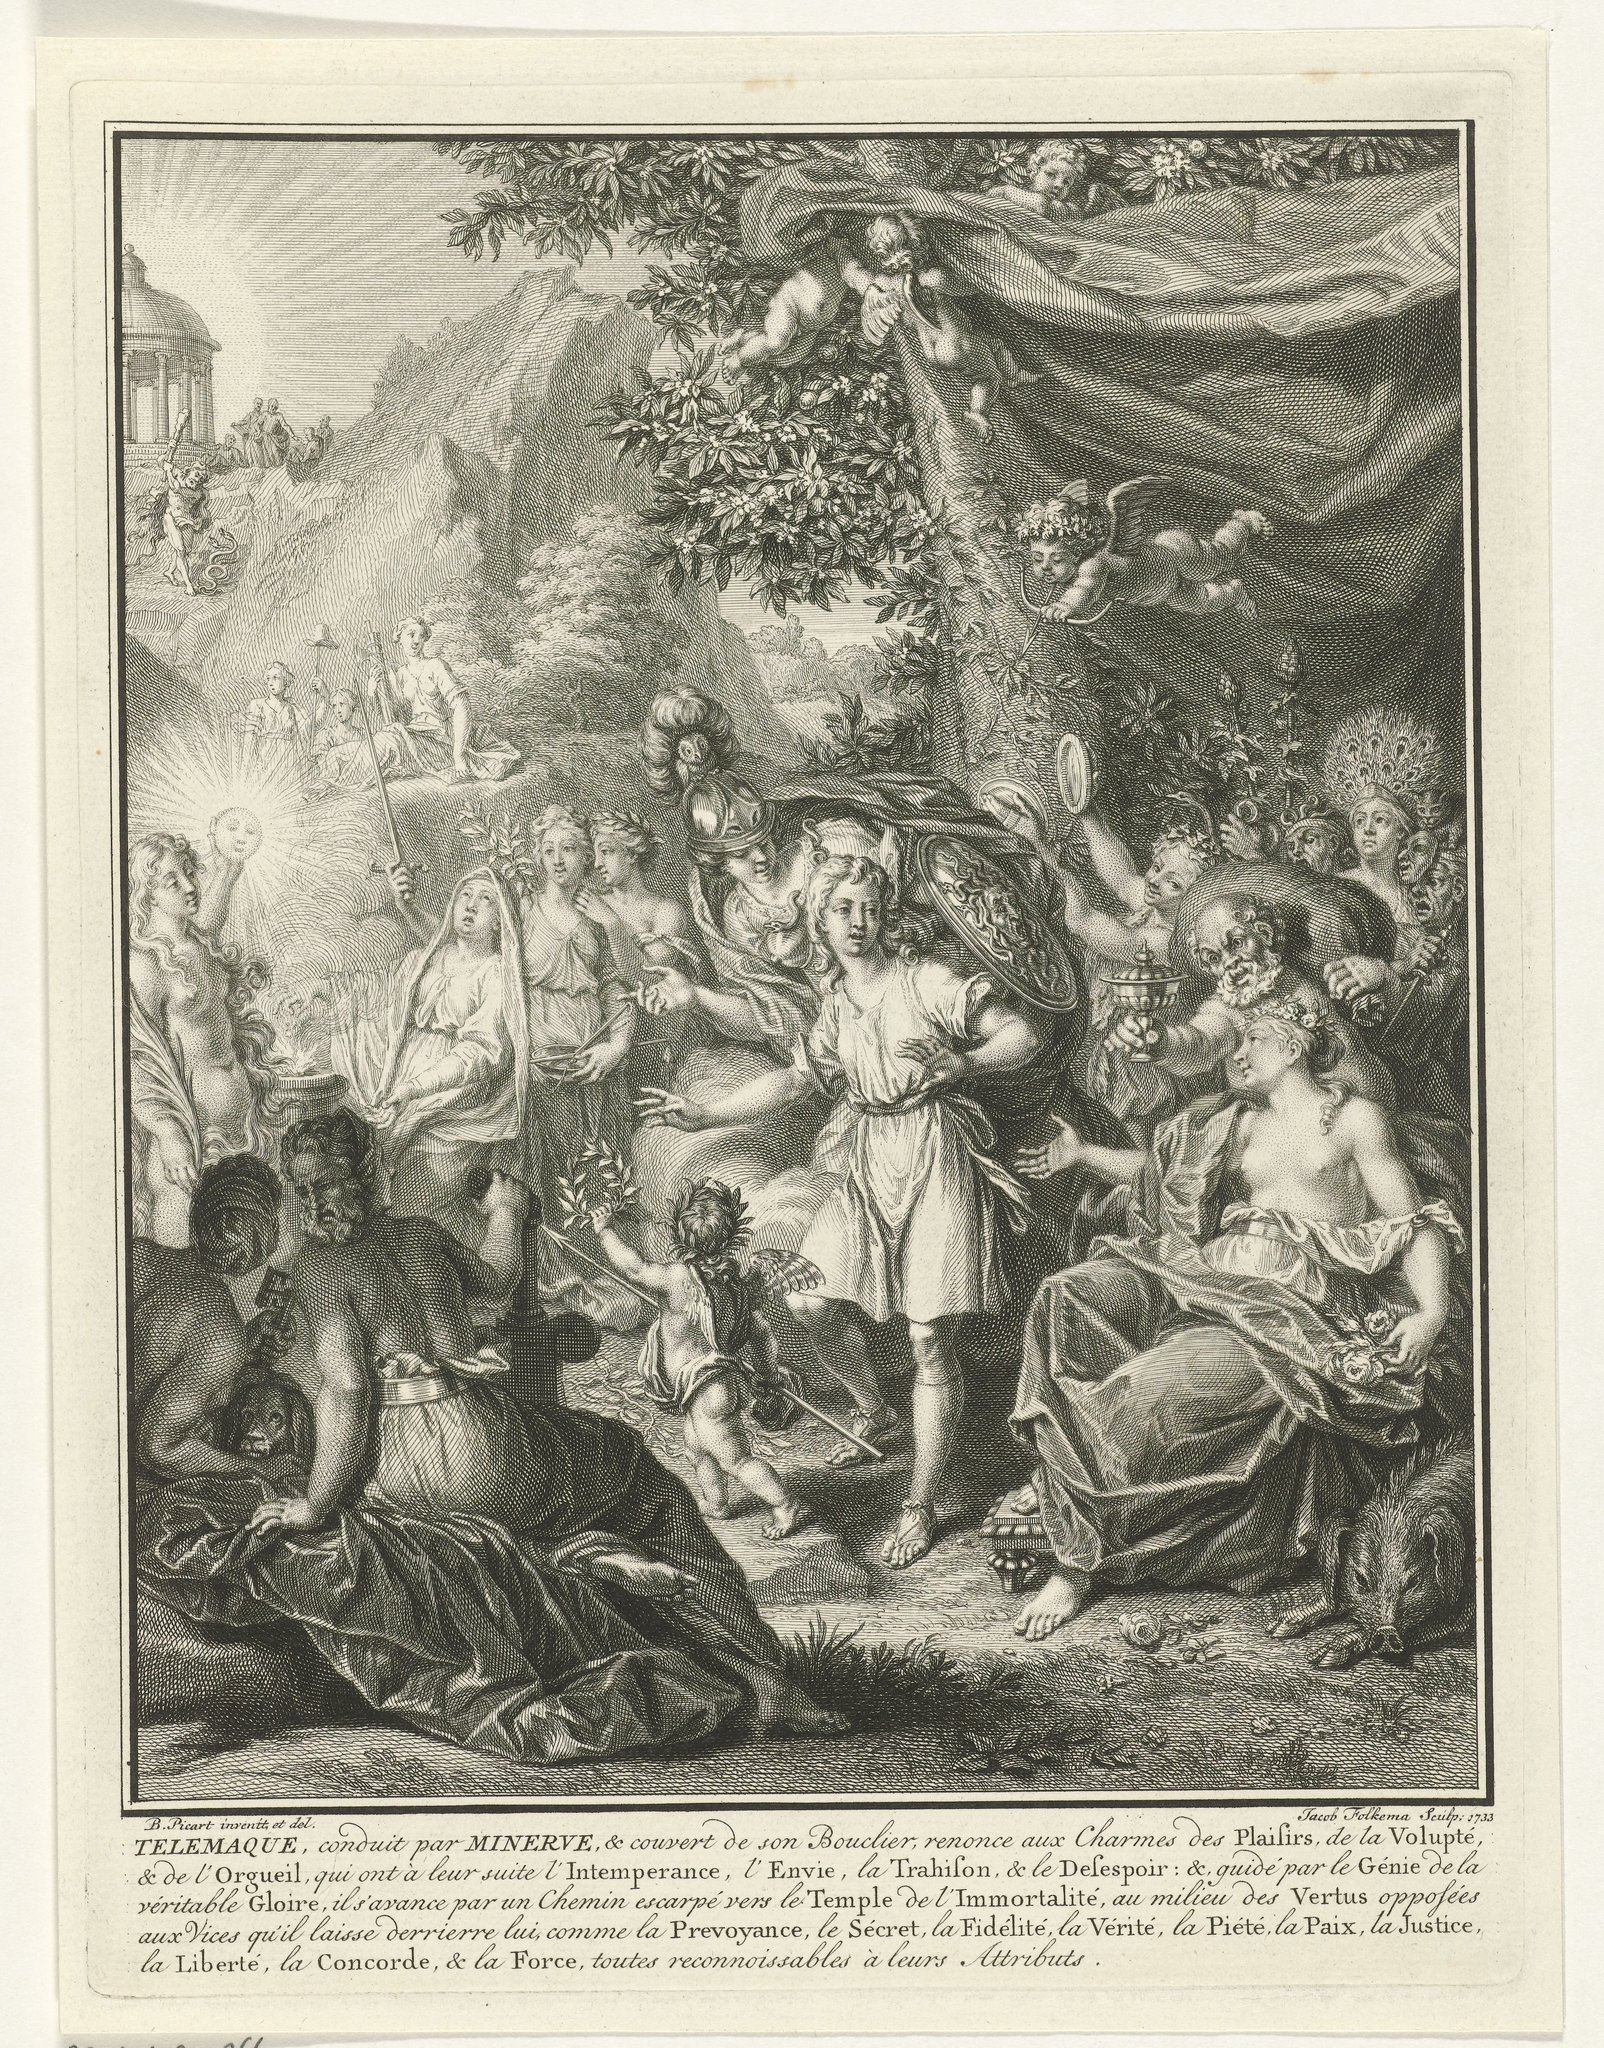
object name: print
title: Allegorische voorstelling met Telemachus en Minerva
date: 1733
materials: paper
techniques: etching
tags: (story of) minerva (pallas, athena), (story of) telemachus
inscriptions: collector's mark: Lugt 2233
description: Telemachus wordt begeleid door Minerva die hem wijst op de talloze allegorische figuren die hen omringen. In de marge staat een vijfregelige tekst in het Frans waarin de voorstelling nader wordt toegelicht. Illustratie vervaardigd bij een verhaal uit "Avonturen van Telemachus", geschreven door François de Fénélon.